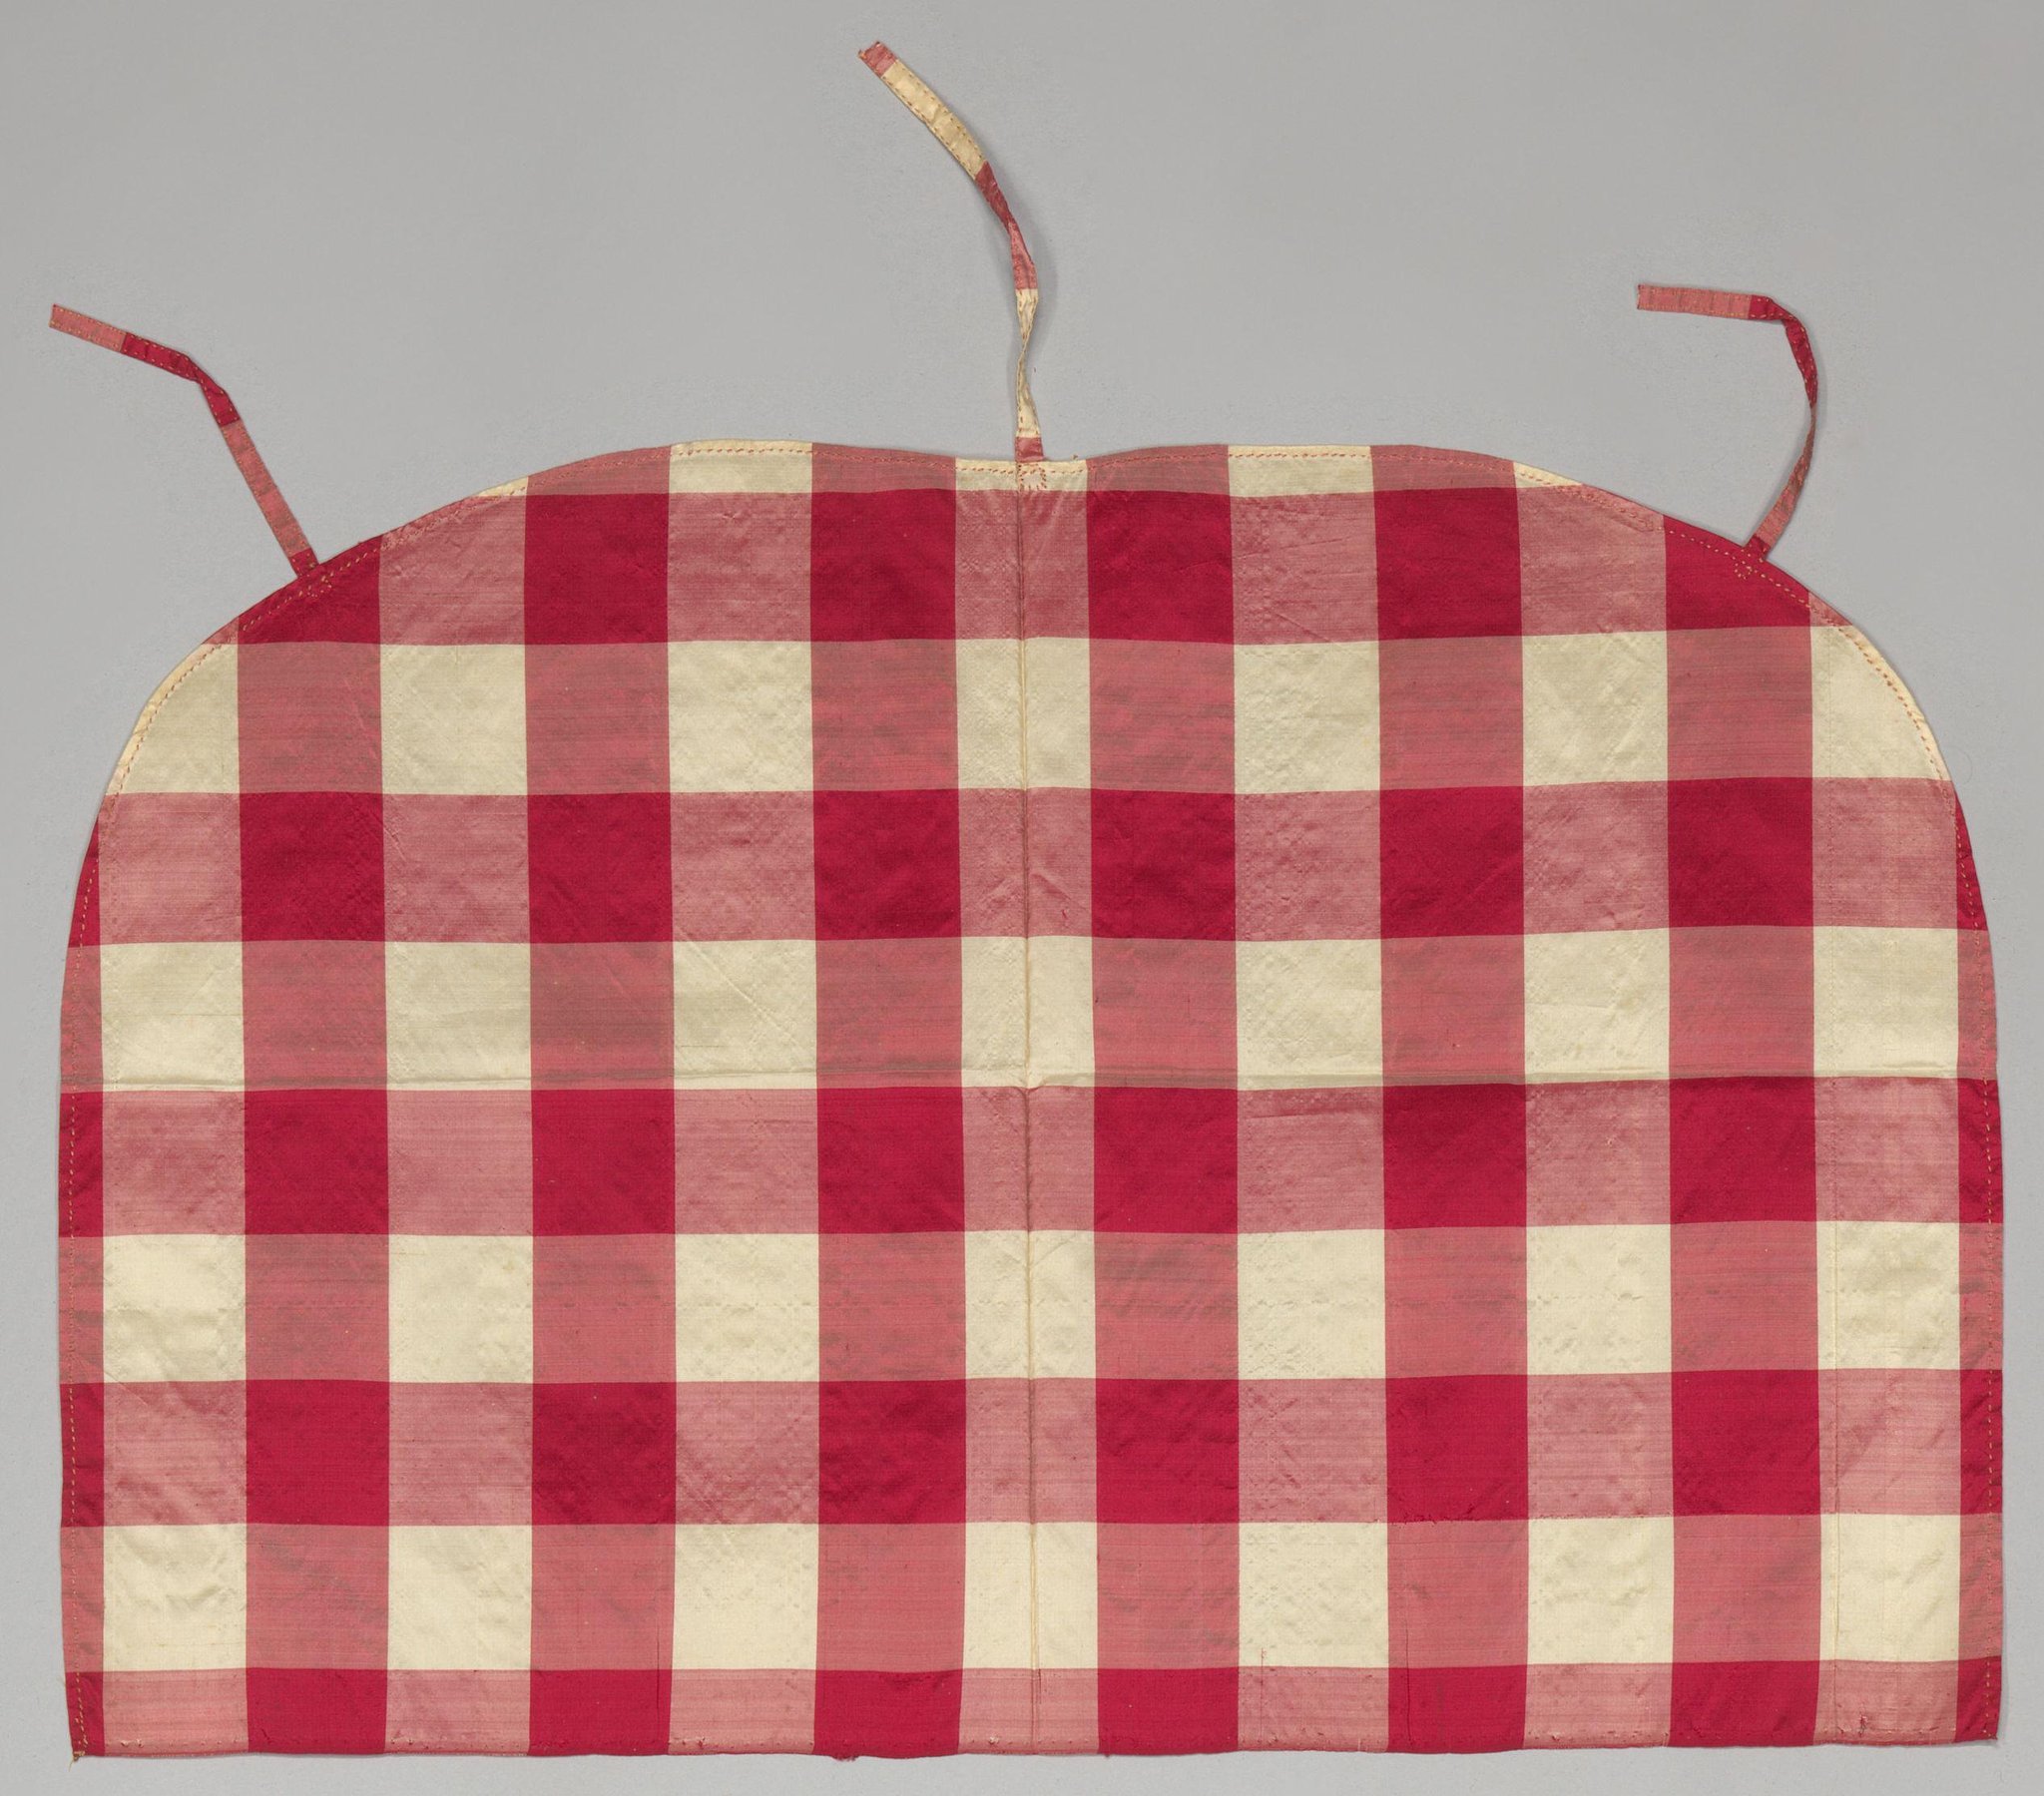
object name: gordijngarnituur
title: Gordijngarnituur, mogelijk een gordijnval, van rood-wit geblokte zijde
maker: Anonymous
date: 1776-1800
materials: silk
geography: northern netherlands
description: Schildvormig gordijngarnituur, mogelijk een gordijnval, met drie bandjes van dezelfde stof van ca. 10.0 cm.